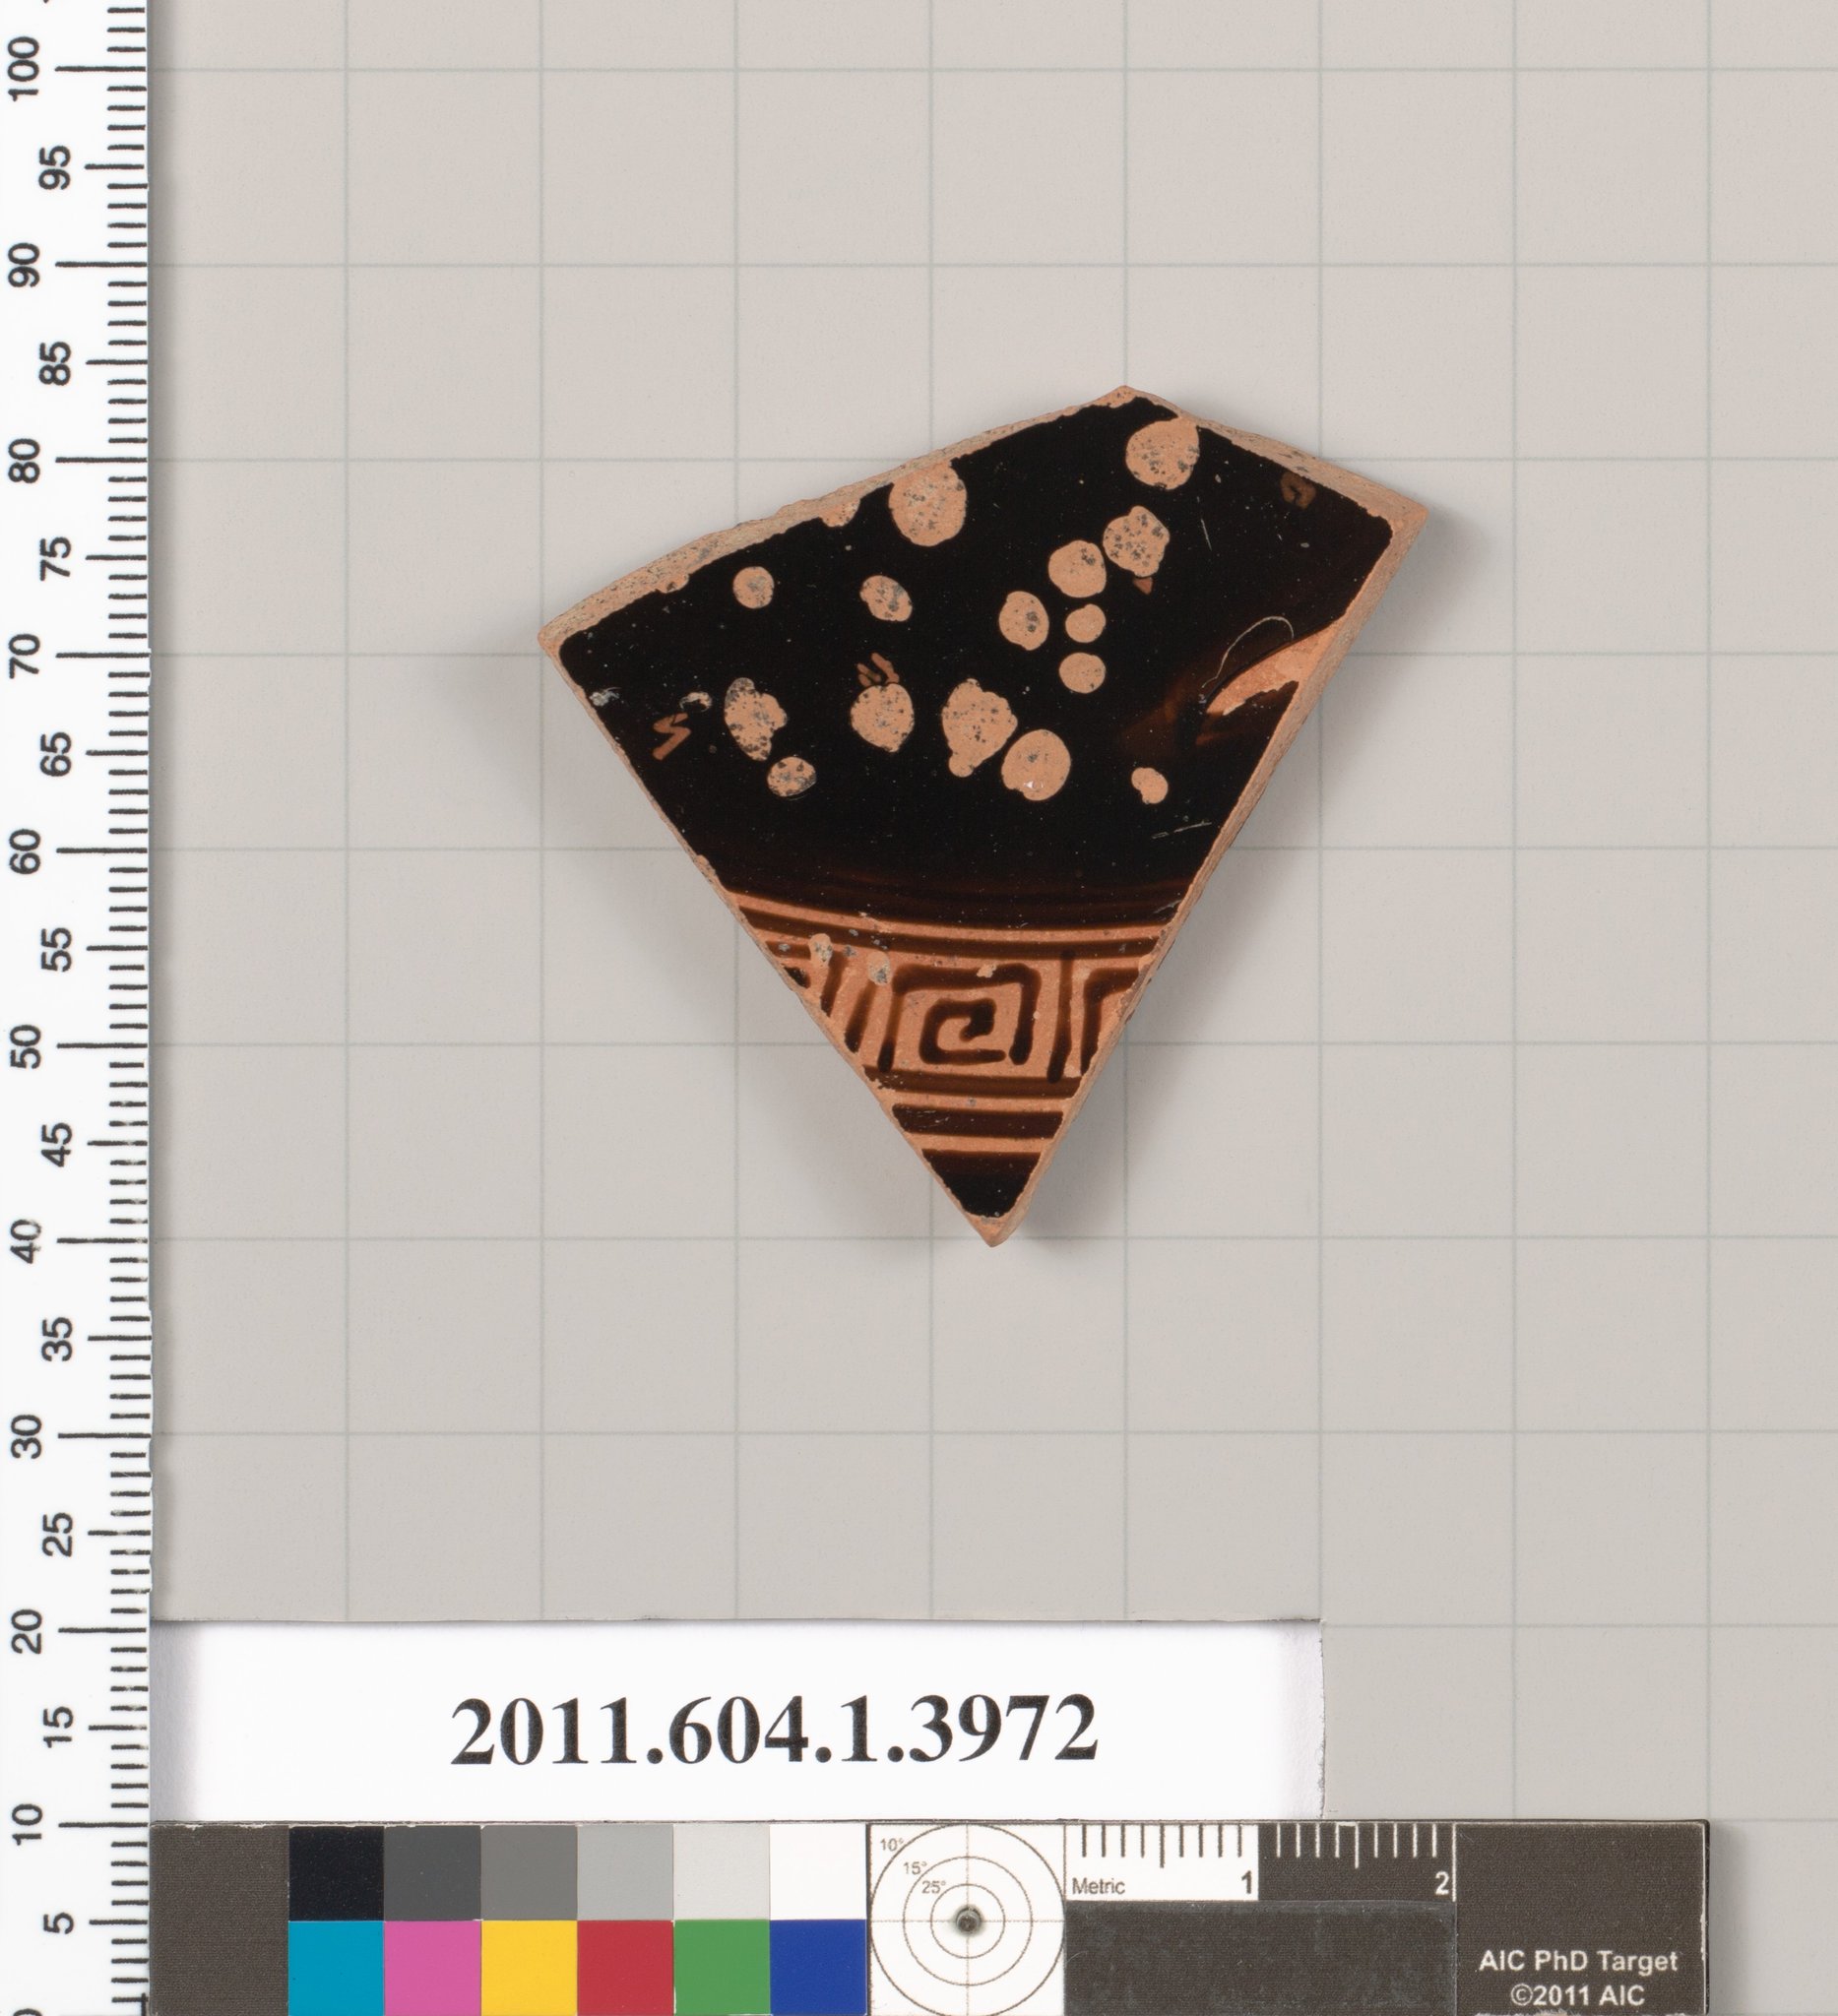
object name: kylix fragment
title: Terracotta fragment of a kylix (drinking cup)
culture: greek, attic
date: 475-451 BCE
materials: terracotta